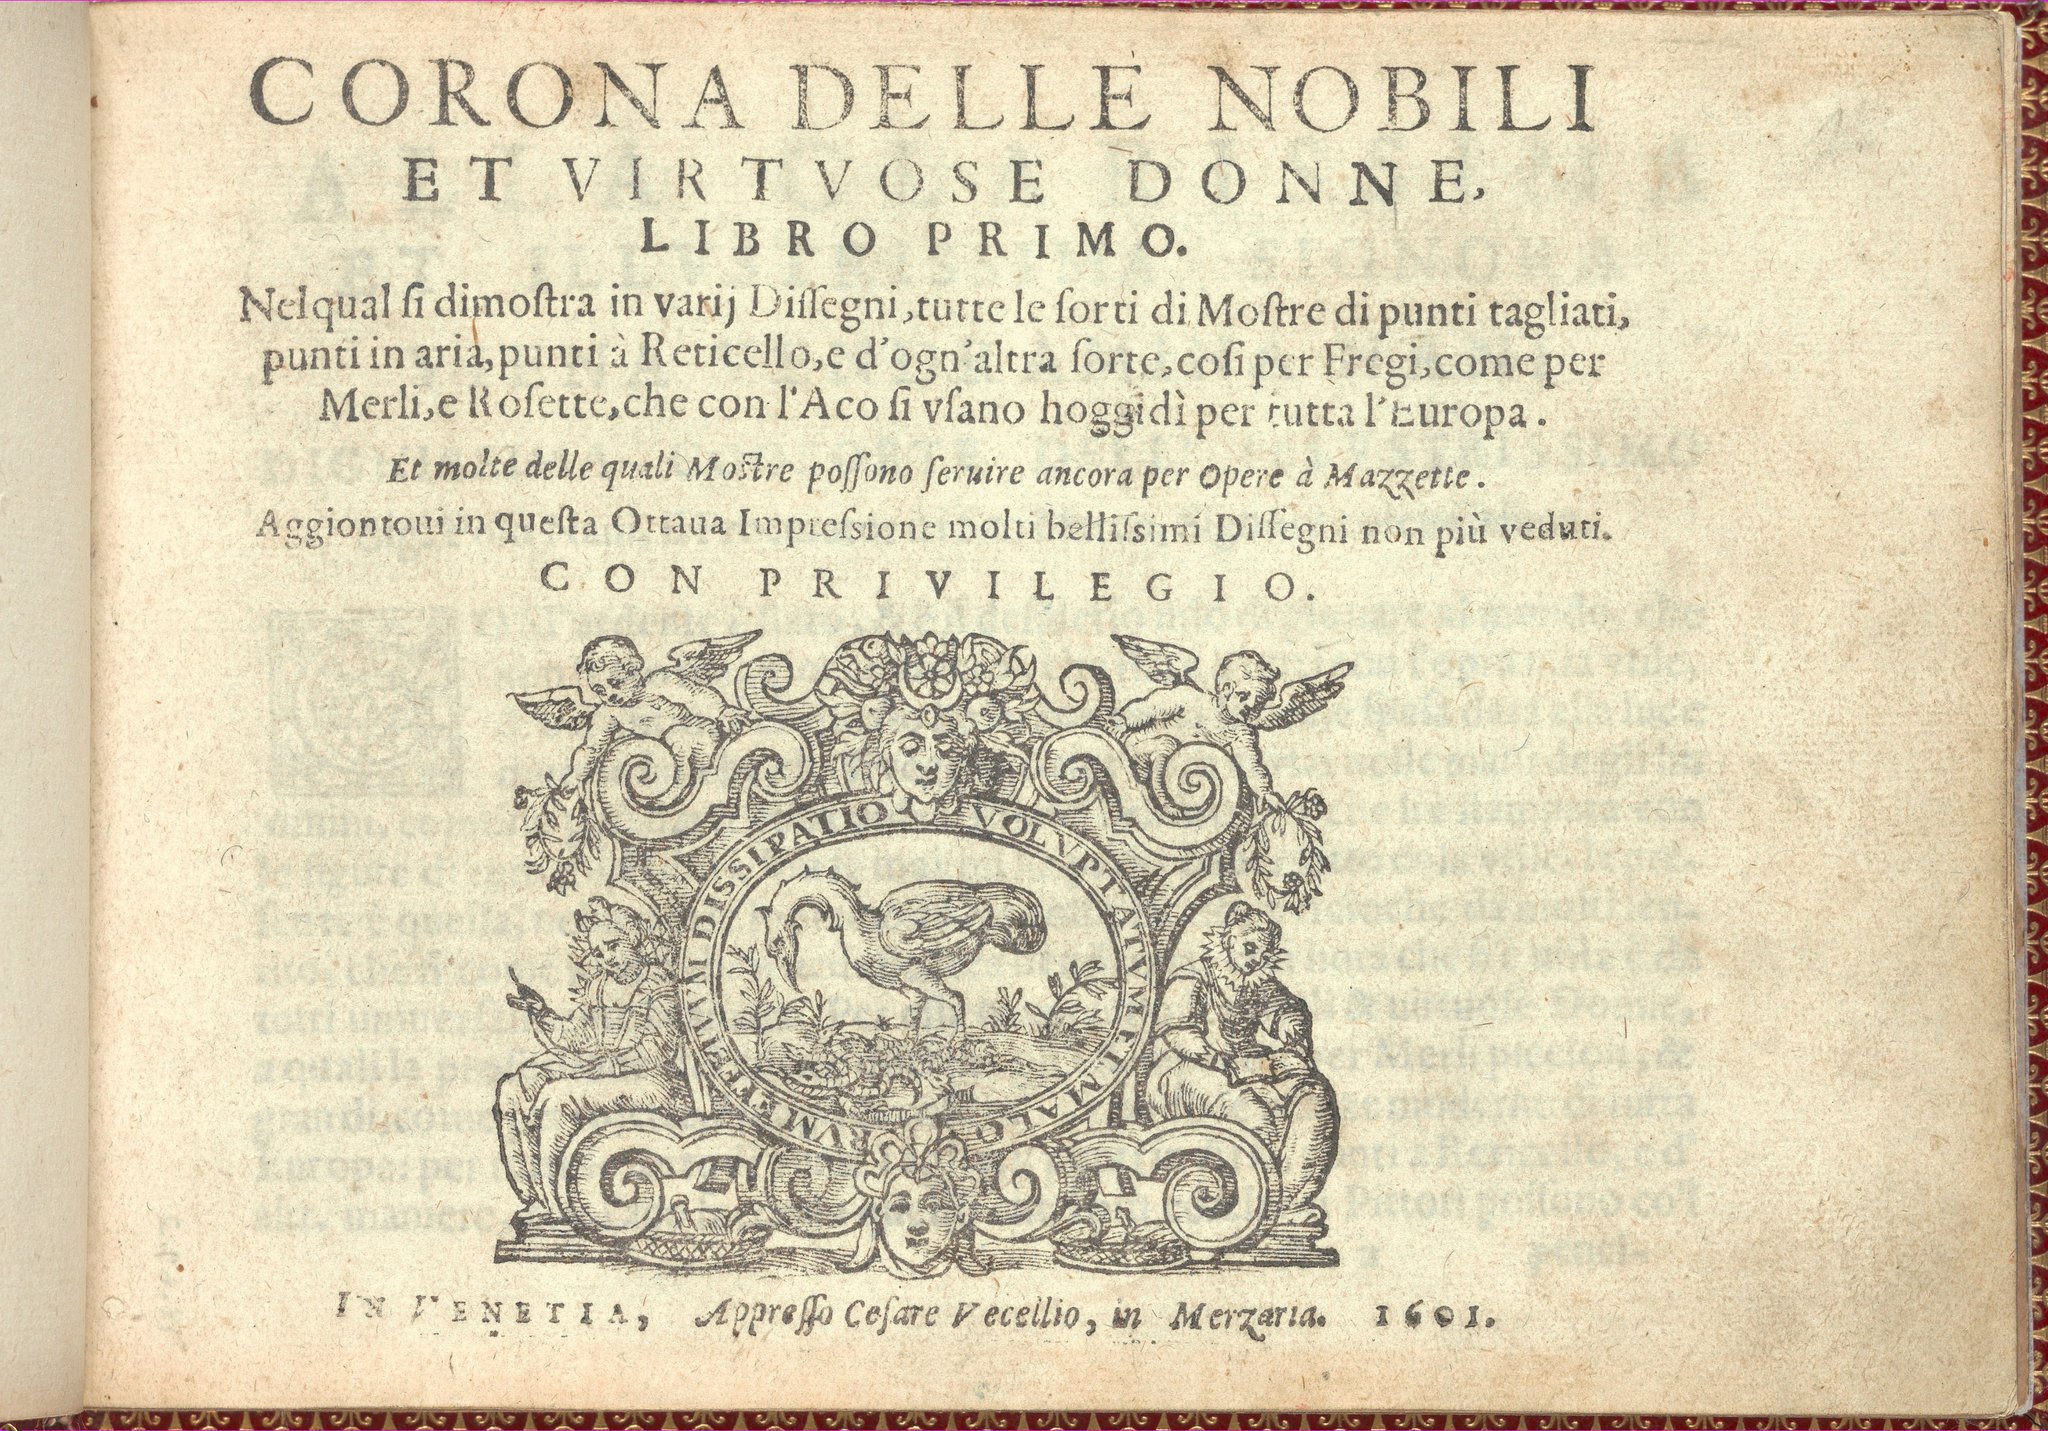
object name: book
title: Corona delle Nobili et Virtuose Donne: Libro I-IV, Book I title page (recto)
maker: cesare vecellio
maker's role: publisher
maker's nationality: italian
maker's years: 1521-1601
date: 1601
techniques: woodcut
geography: italy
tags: birds,faces